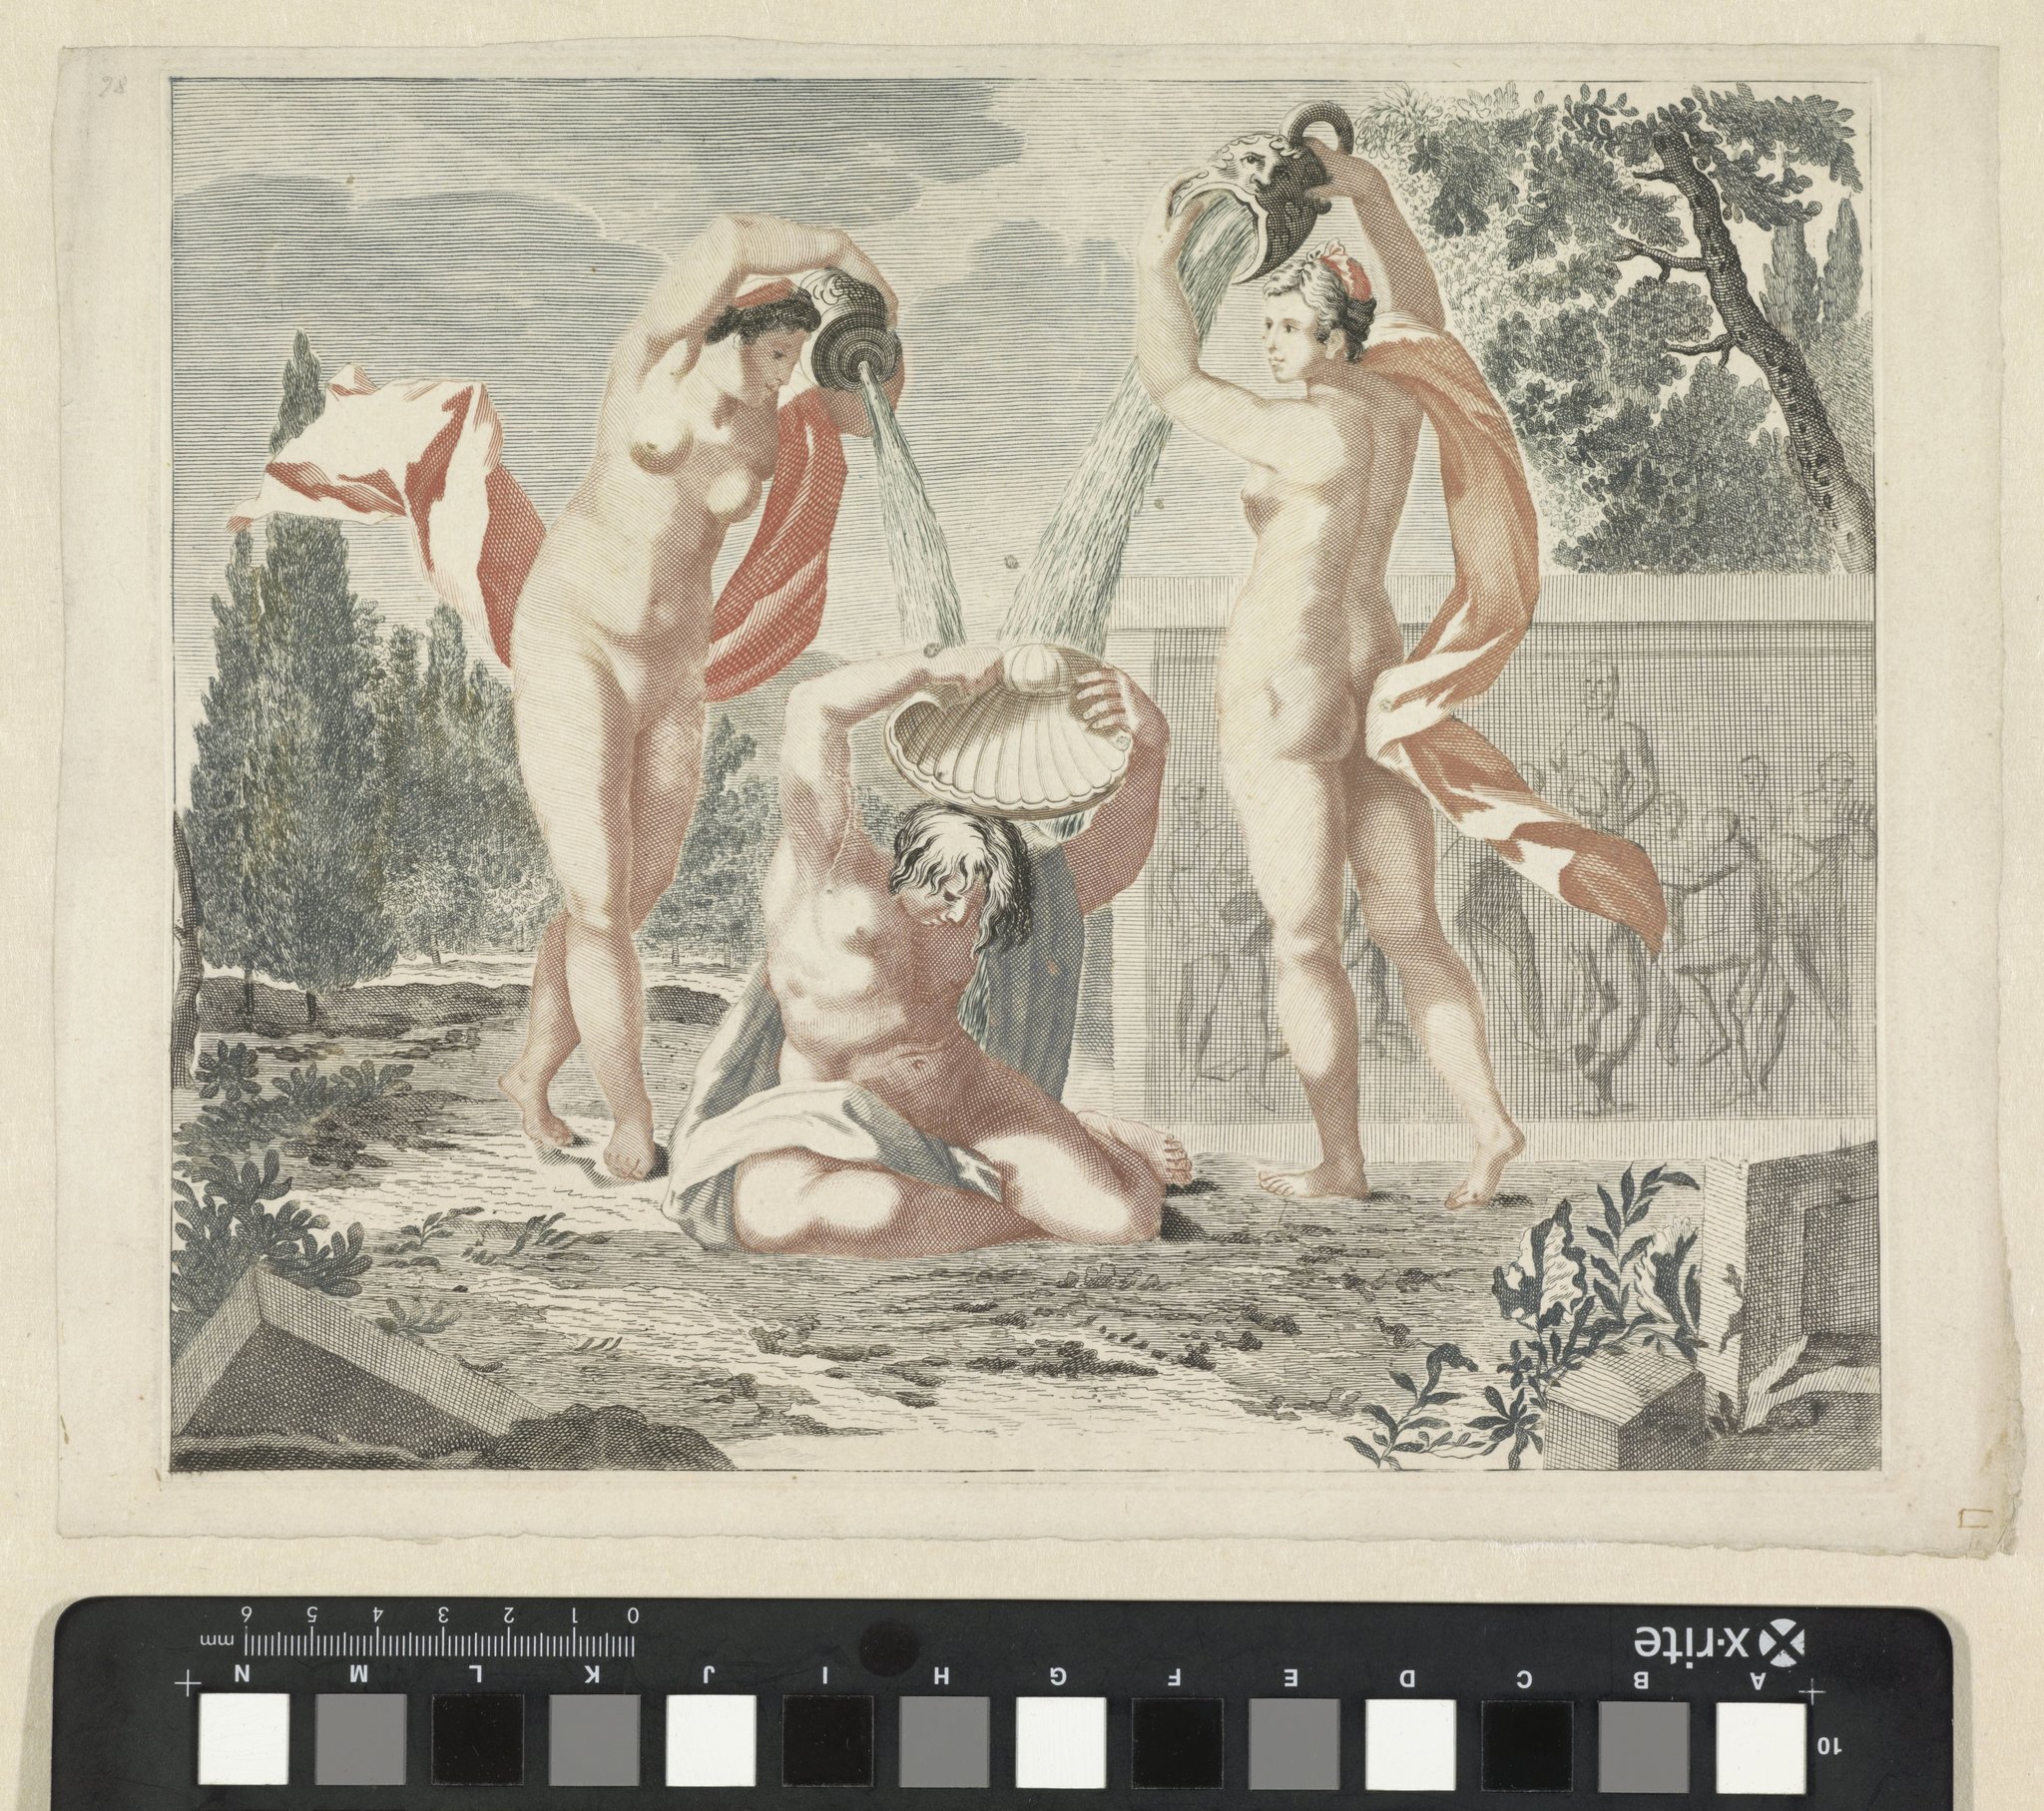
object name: print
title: Twee vrouwen gieten water over een man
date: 1688-1698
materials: paper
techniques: printing, engraving, lithography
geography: netherlands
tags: pouring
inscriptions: collector's mark: Lugt 2228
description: Twee vrouwen gieten uit kruiken water over een man, die een schelp boven zijn hoofd houdt. Rechts een stenen reliëf in het landschap.